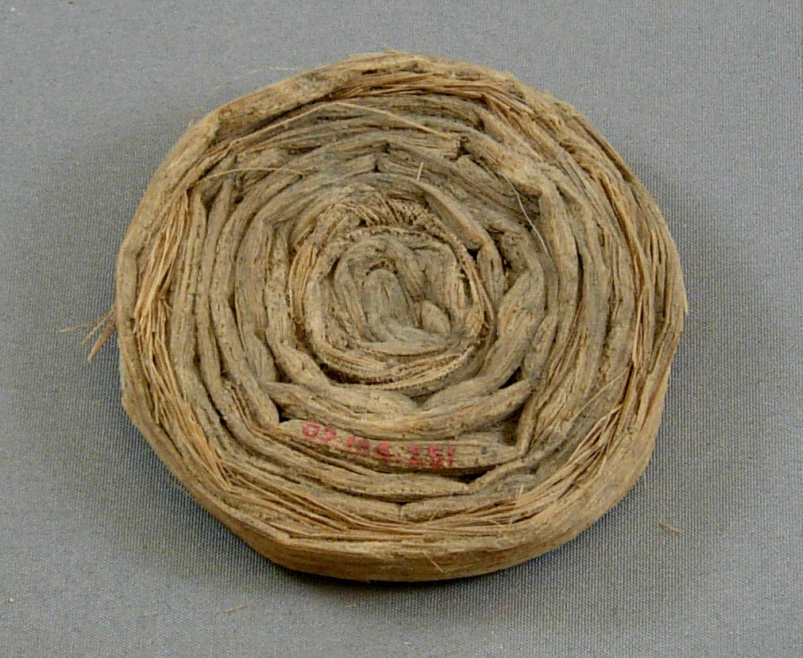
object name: jar lid, papyrus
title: Papyrus Lid from Tutankhamun's Embalming Cache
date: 1336-1327 BCE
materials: fiber, papyrus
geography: egypt